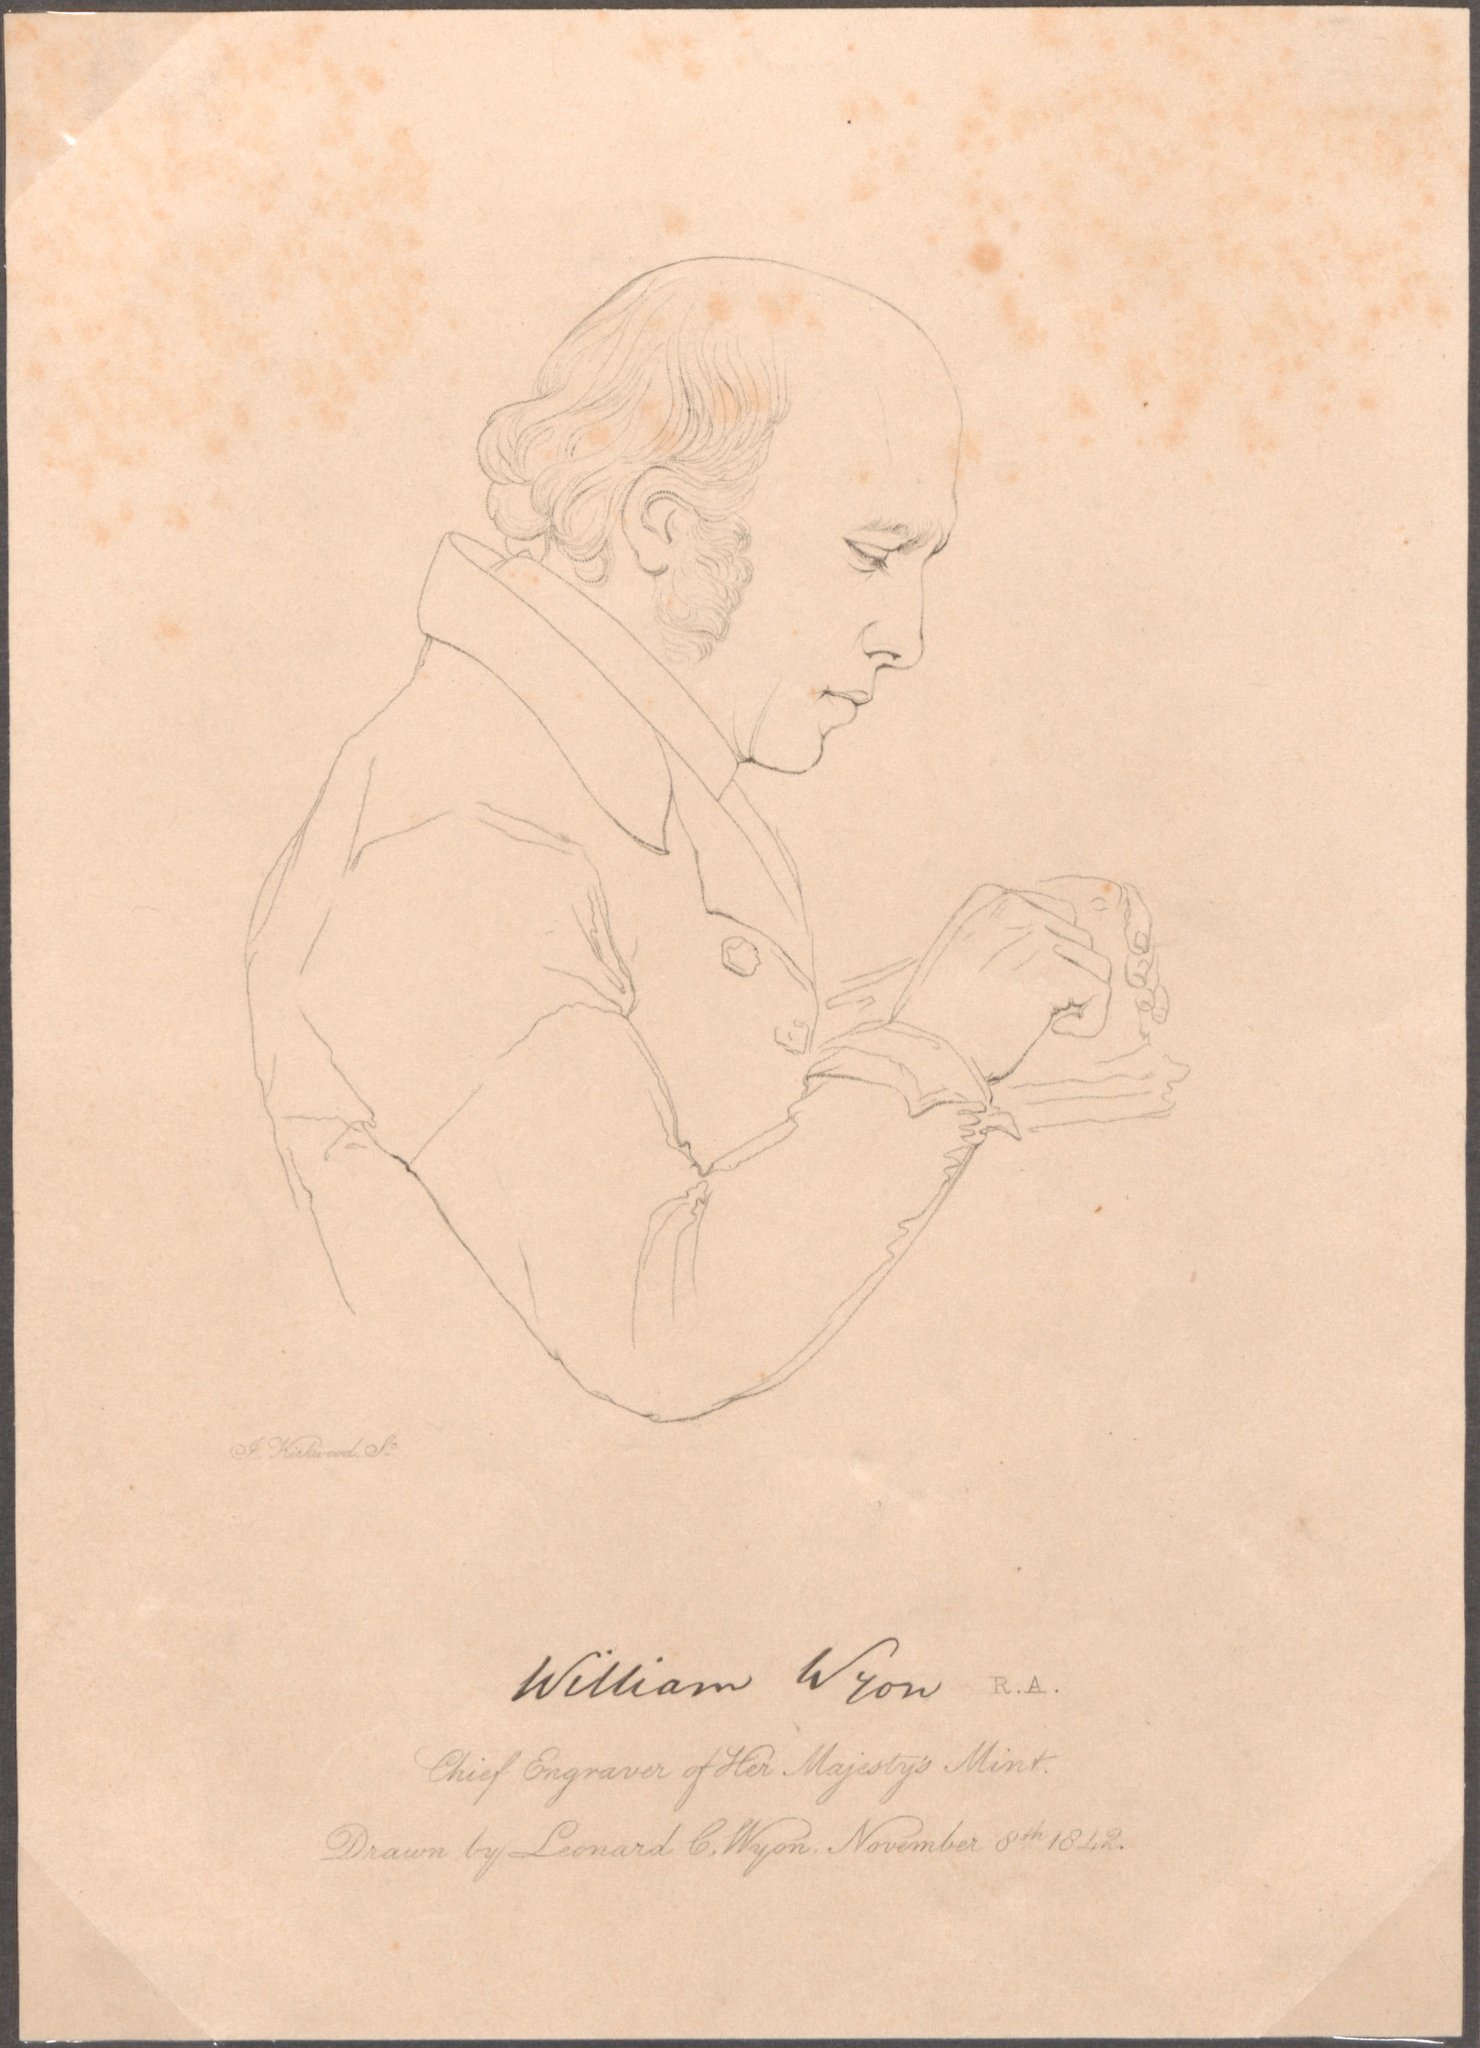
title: William Wyon, R.A., chief engraver of Her Majesty's Mint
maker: leonard charles wyon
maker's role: artist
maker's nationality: british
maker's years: 1826-1891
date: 1842